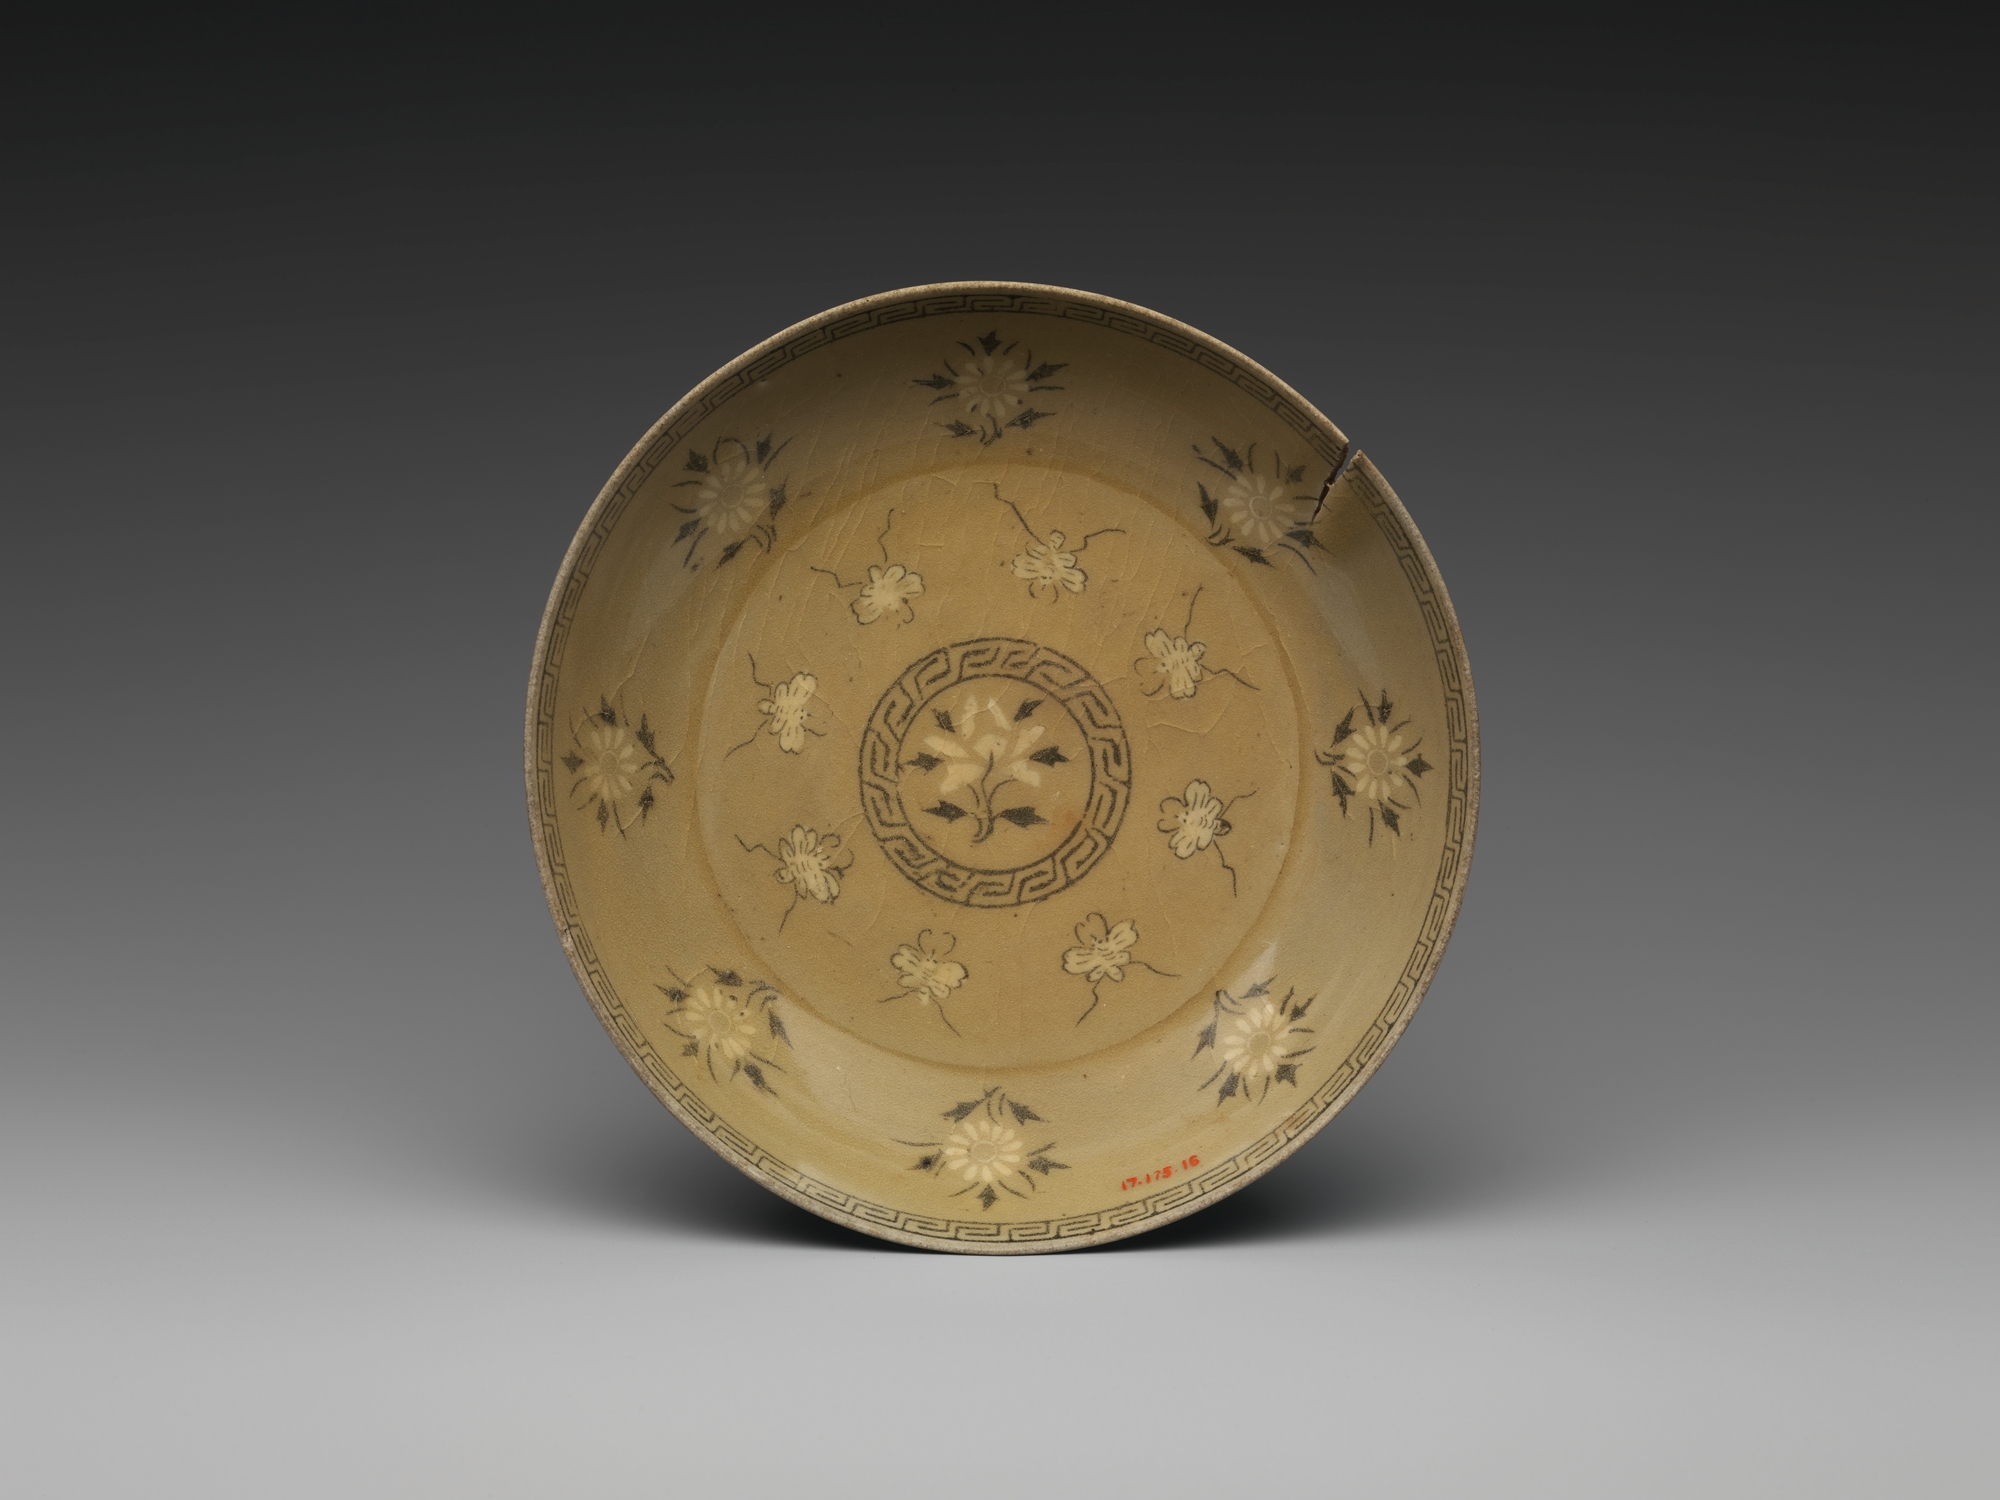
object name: saucer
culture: korean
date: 918-1392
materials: clay